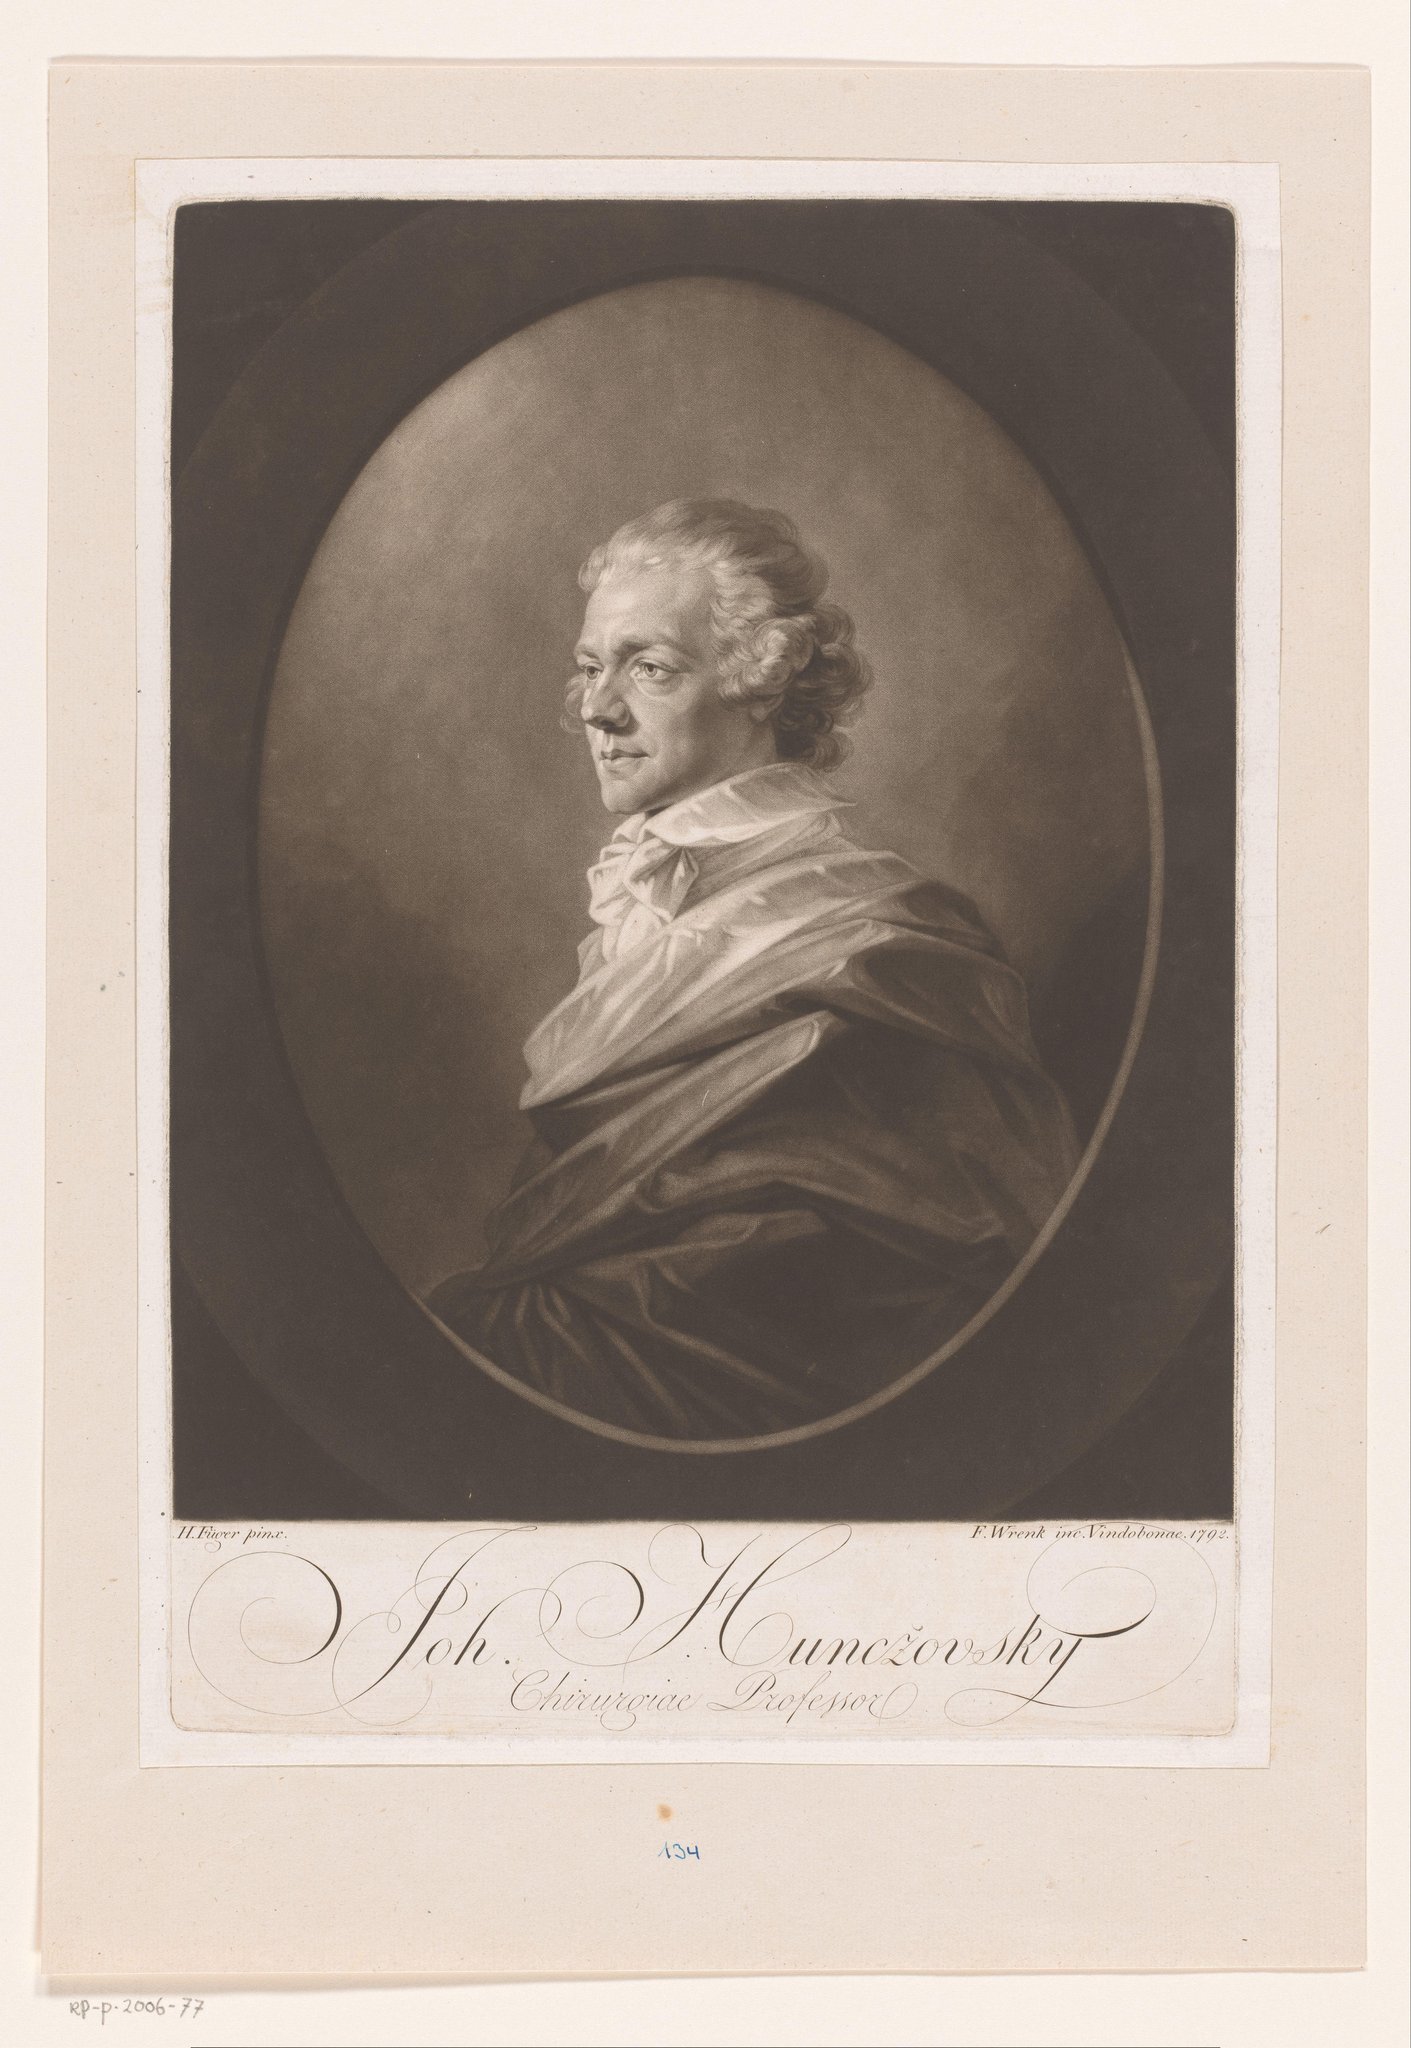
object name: print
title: Portret van Johann Huncžovsky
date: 1792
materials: paper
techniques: mezzotint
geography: vienna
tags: vienna, historical persons, physician, doctor (+ portrait of scholar, scientist)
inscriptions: collector's mark: Lugt 2228, collector's mark: Lugt 2760